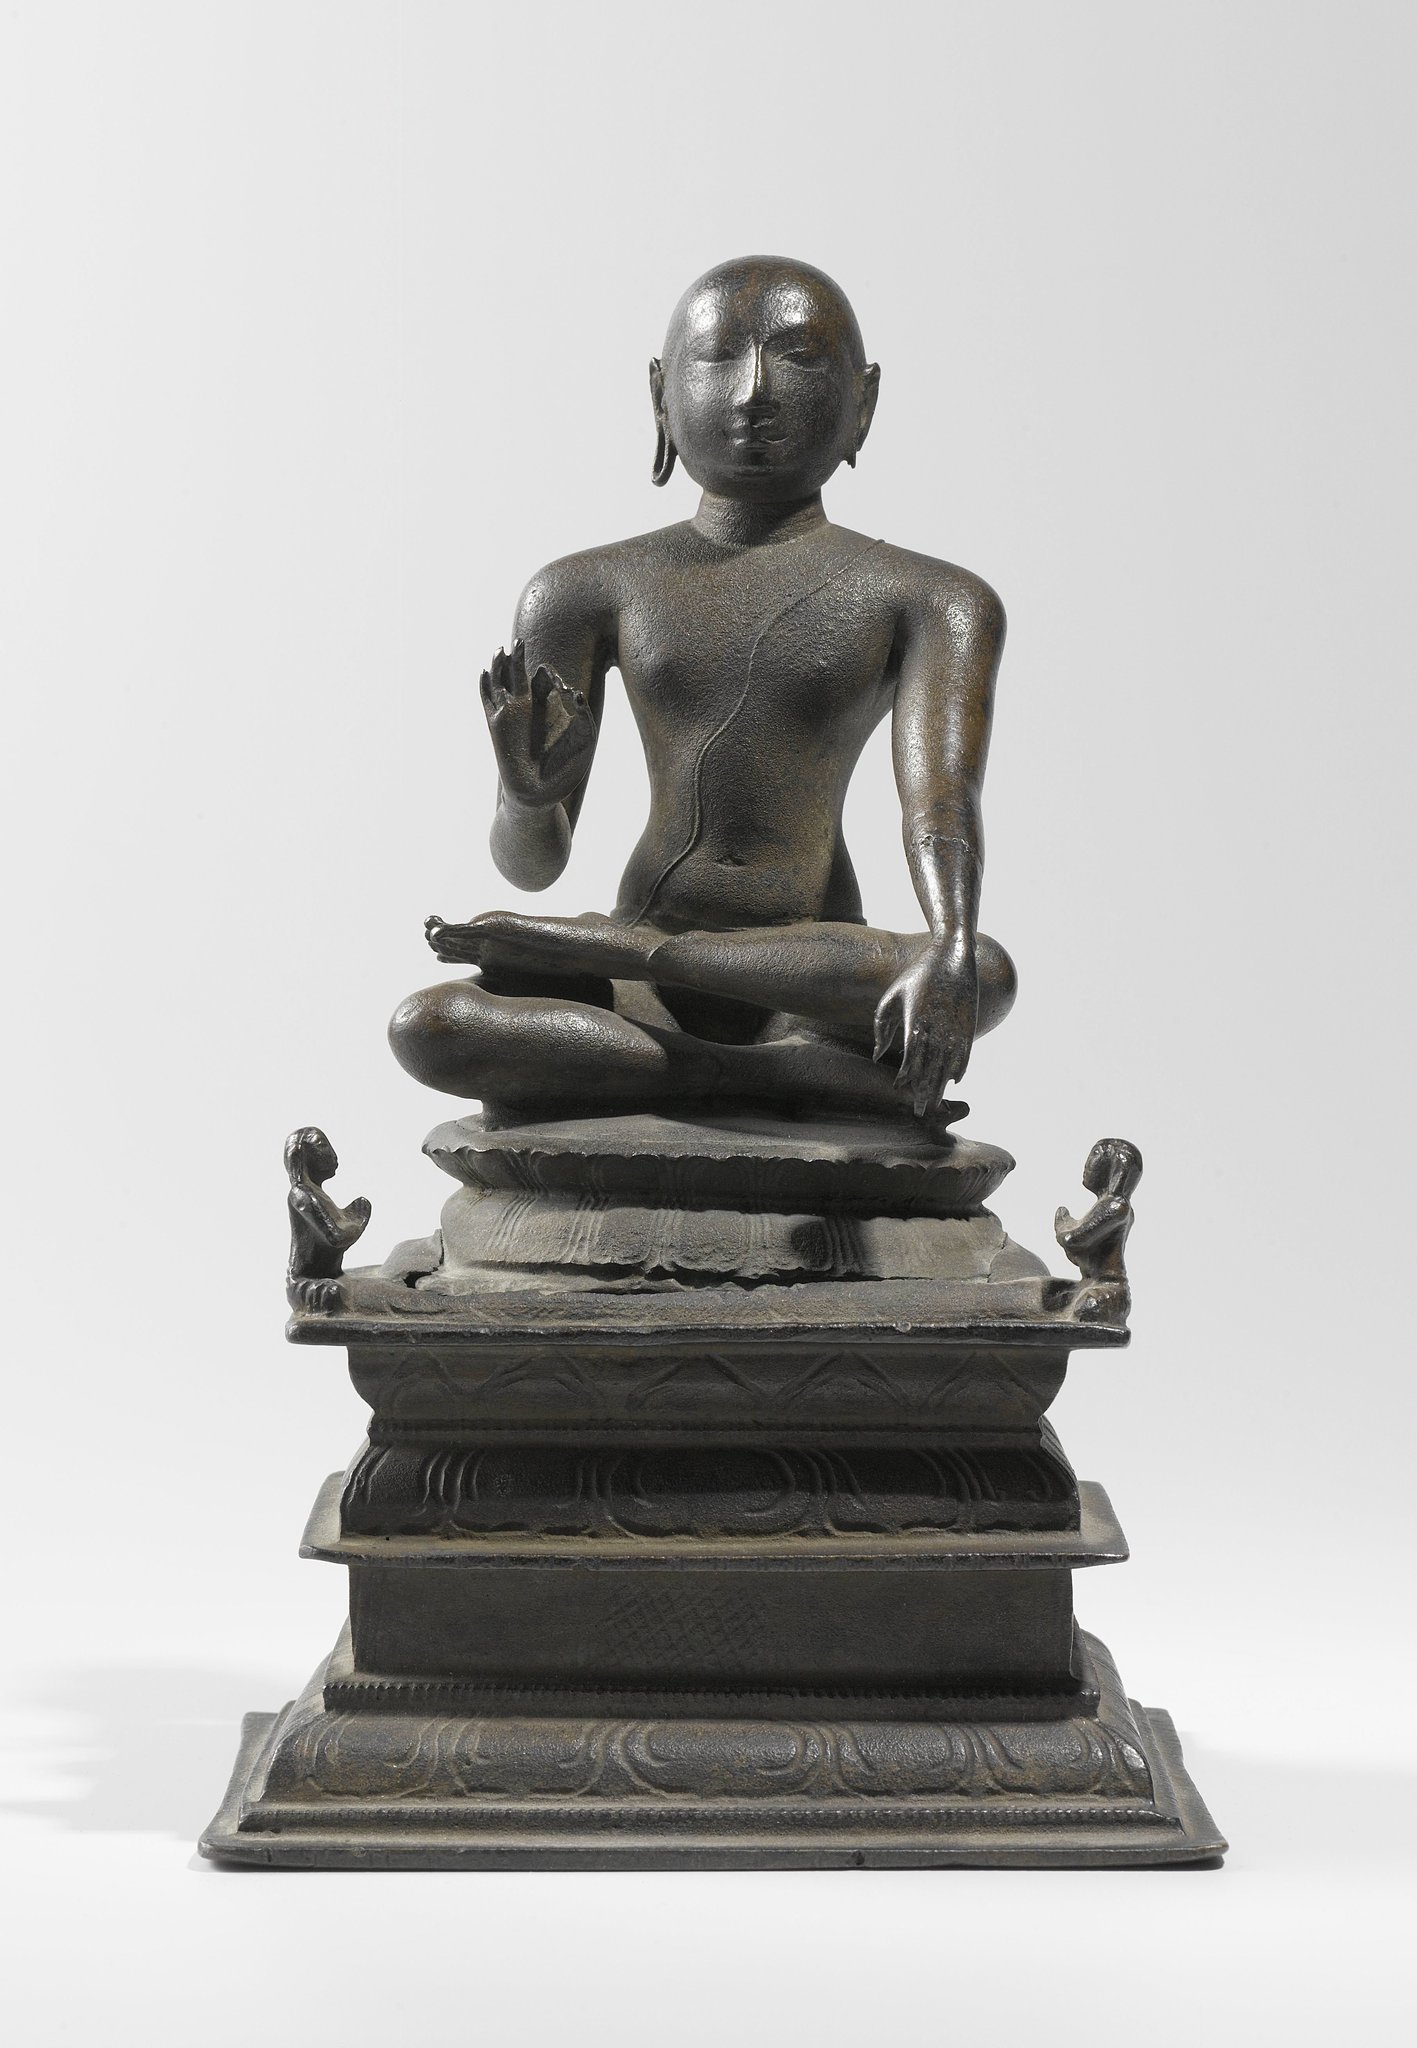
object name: sculpture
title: Religious teacher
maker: Anonymous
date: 1300-1400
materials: bronze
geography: karnataka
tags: hinduism, buddhism, jainism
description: This teacher’s right hand makes the gesture of edification (vitarka mudra). This statue may represent one of the Alvars, the poets-saints who dedicated themselves to the god Vishnu. The making of bronze images of these mystics and their veneration began around the 10th century in Tamil Nadu, under the Chola Dynasty. From this time on, their poems also became an integral part of the temple liturgy.